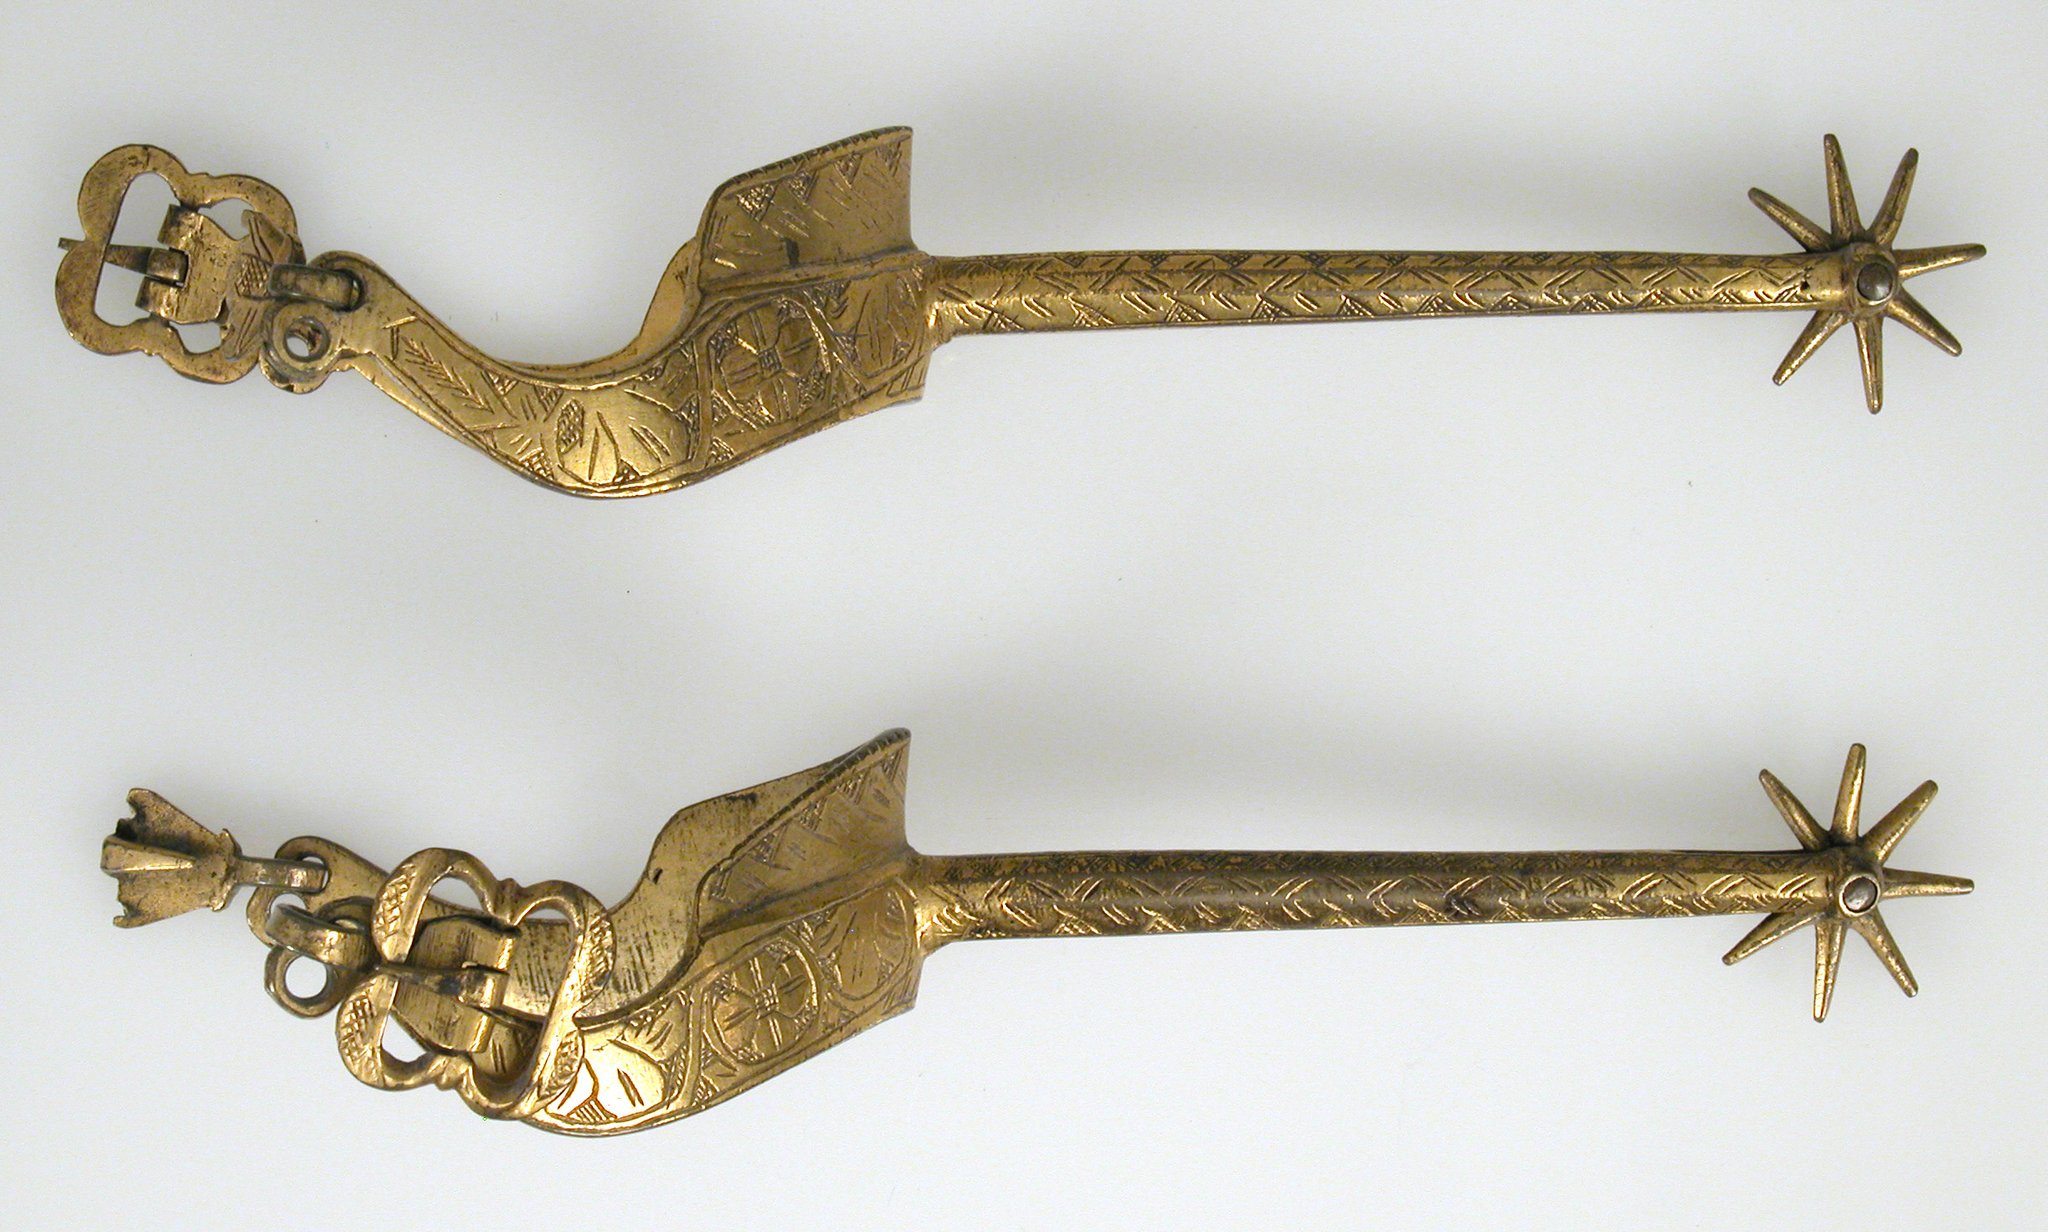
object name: spur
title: Pair of Rowel Spurs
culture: german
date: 1401-1500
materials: copper alloy, gold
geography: germany